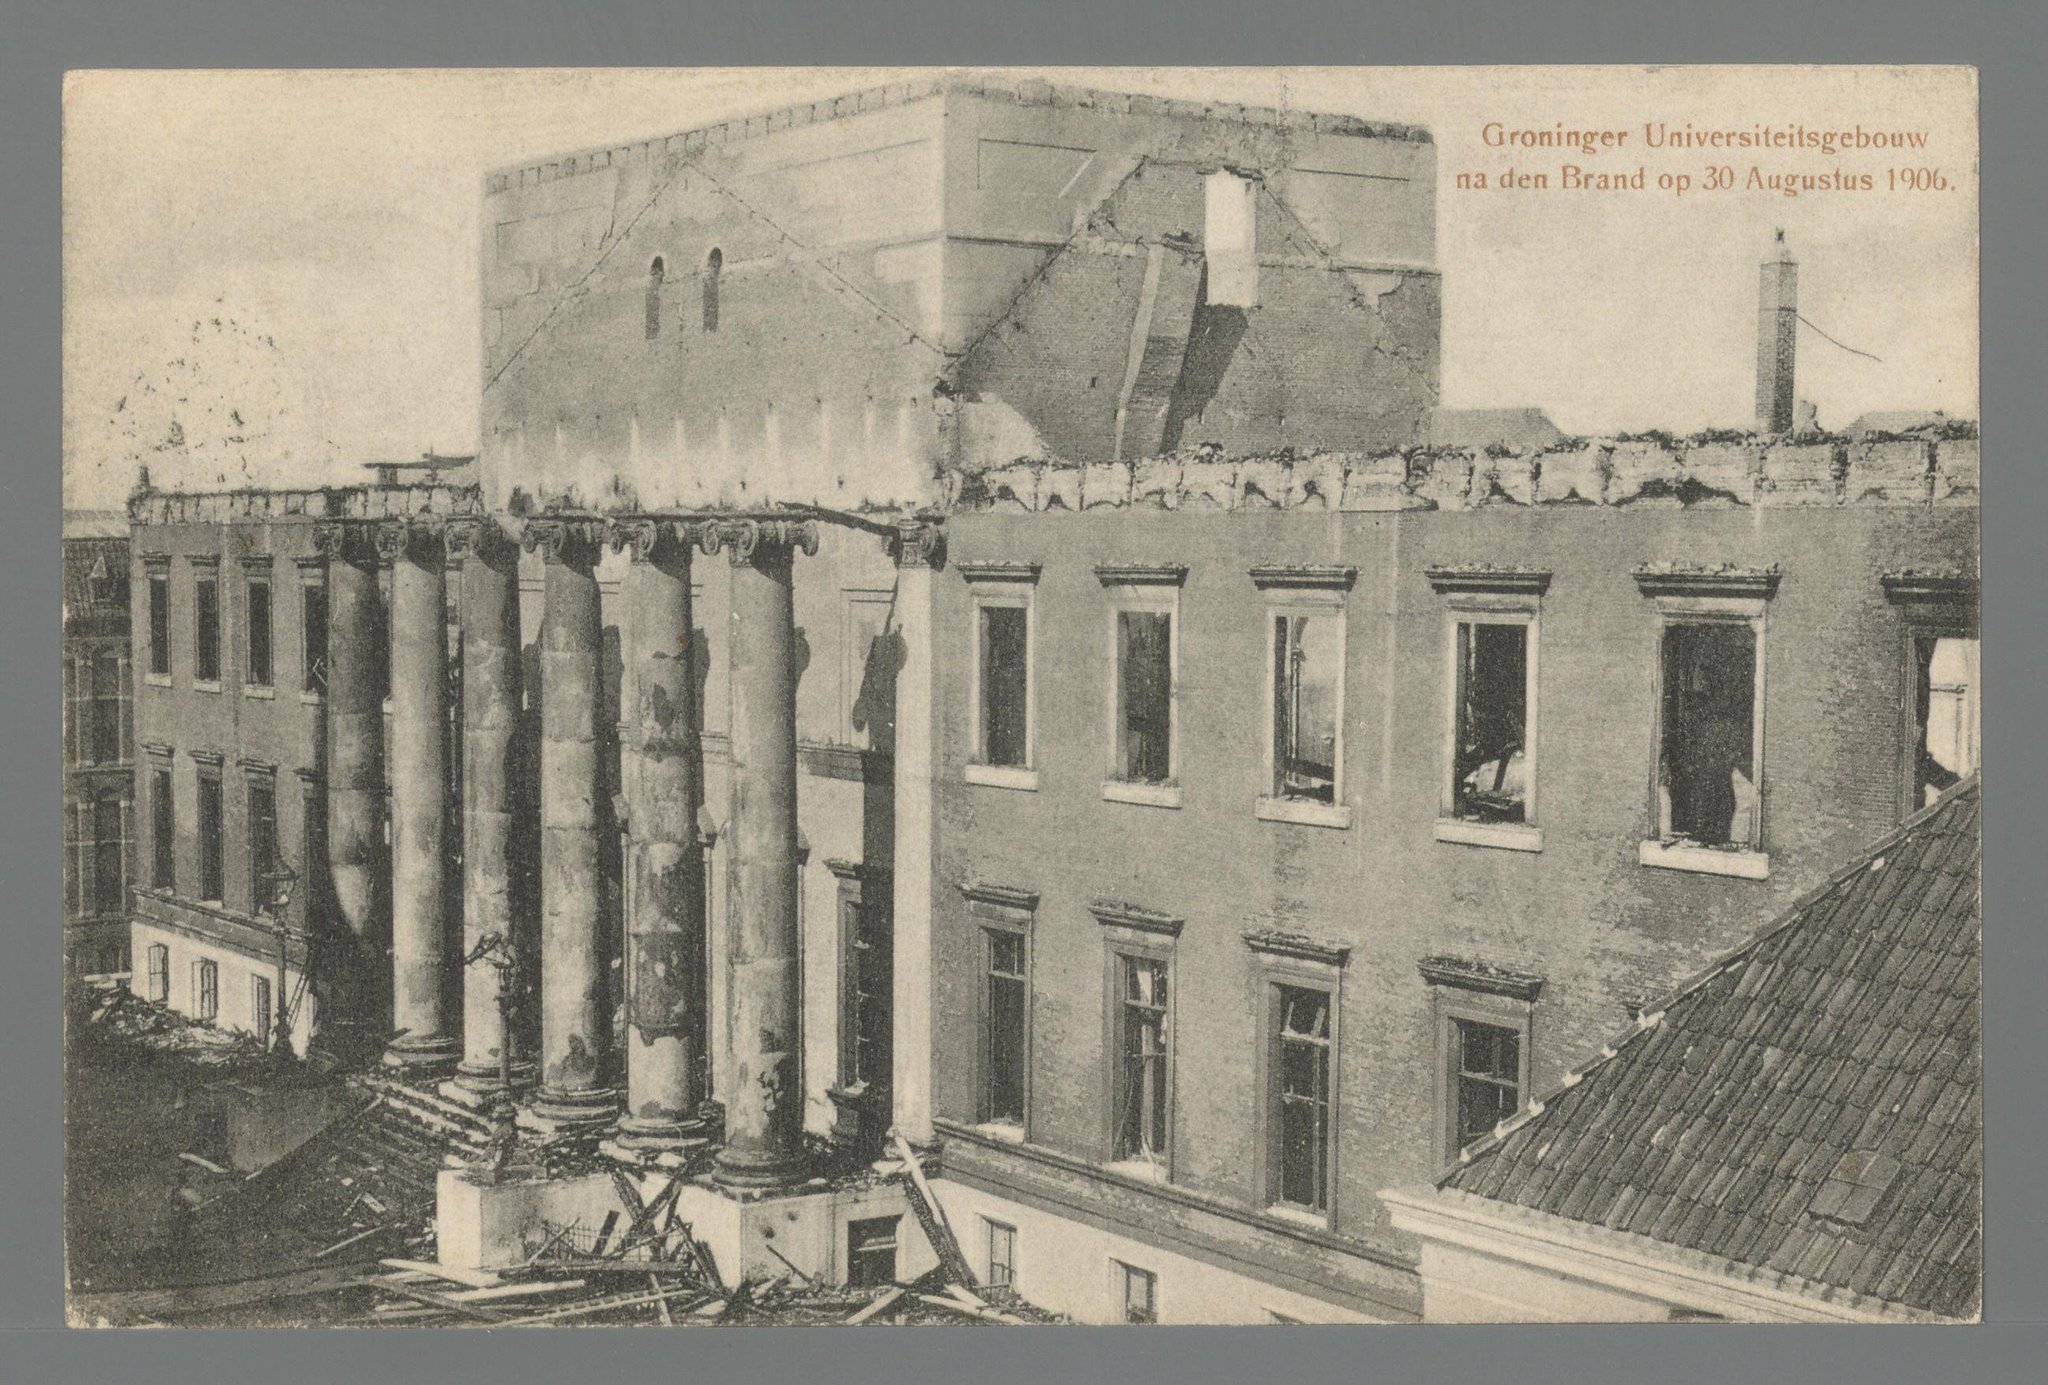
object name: ansichtkaart, prentbriefkaart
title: Groninger Universiteitsgebouw na den brand op 30 augustus 1906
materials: cardboard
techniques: photograph, writing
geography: groningen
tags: university building, college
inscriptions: postage stamp